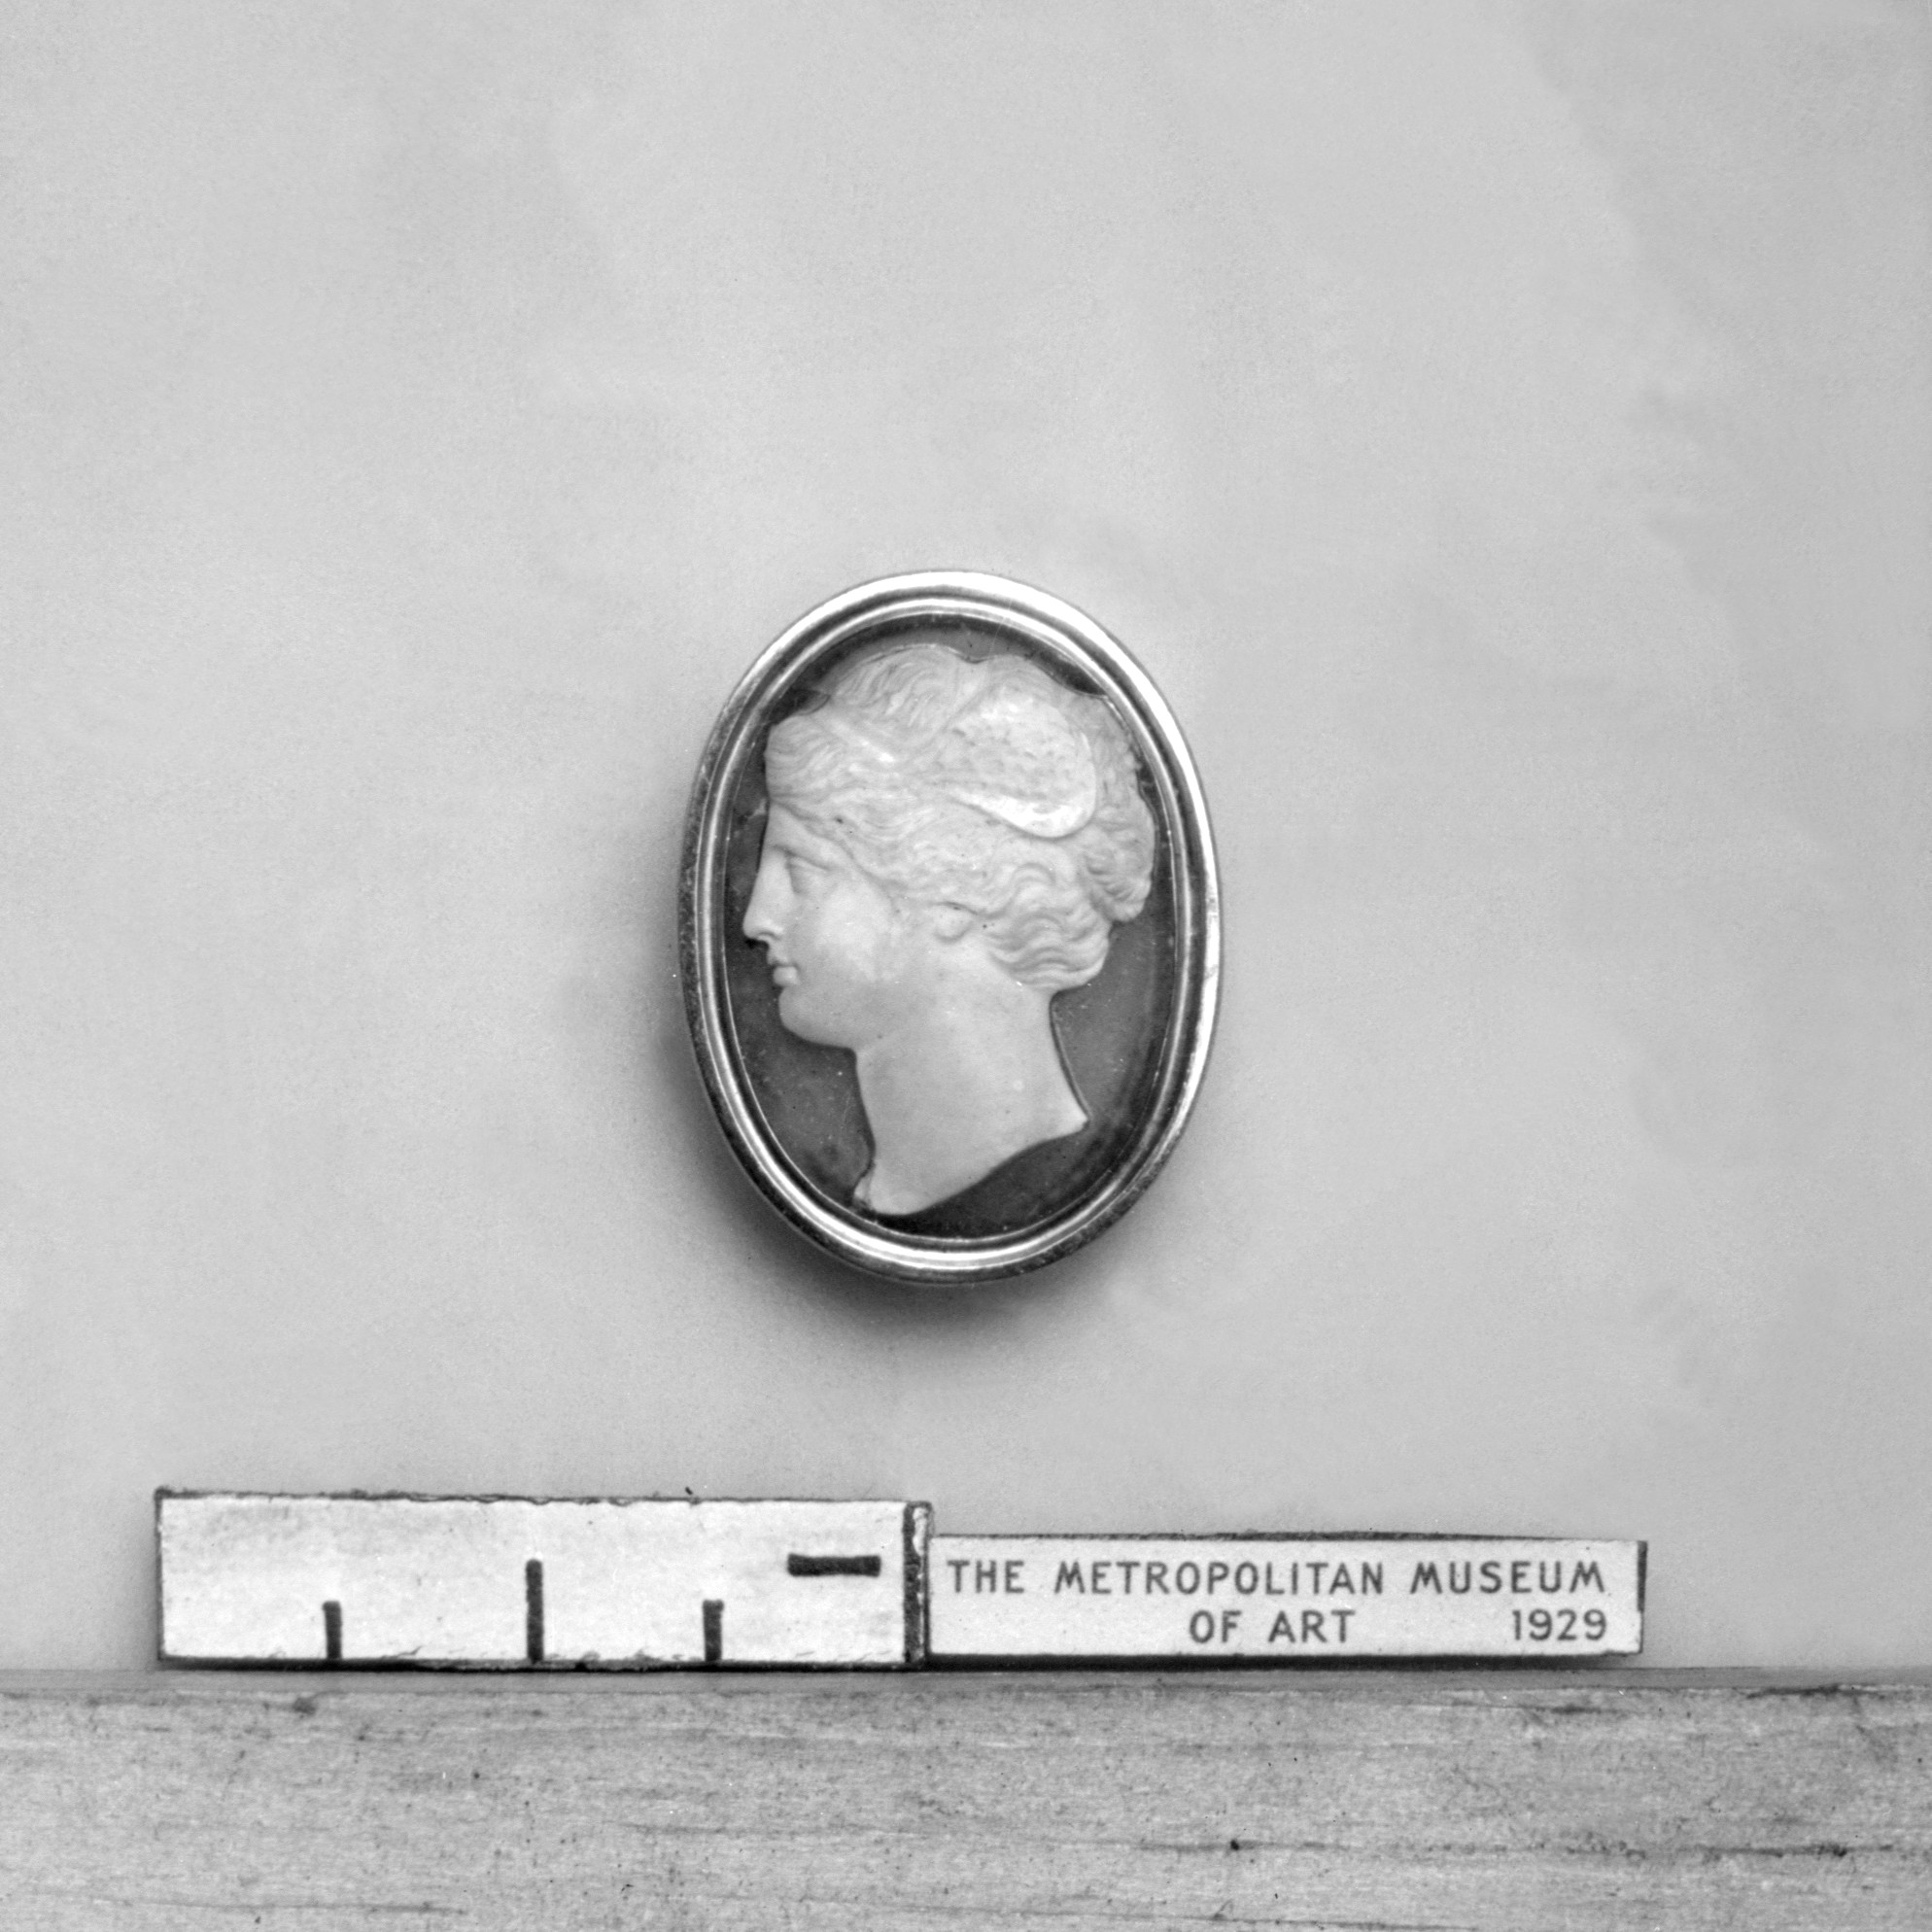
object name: cameo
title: Psyche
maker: mastini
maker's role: artist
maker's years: 1750-1850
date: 1801-1850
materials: gold, onyx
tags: psyche